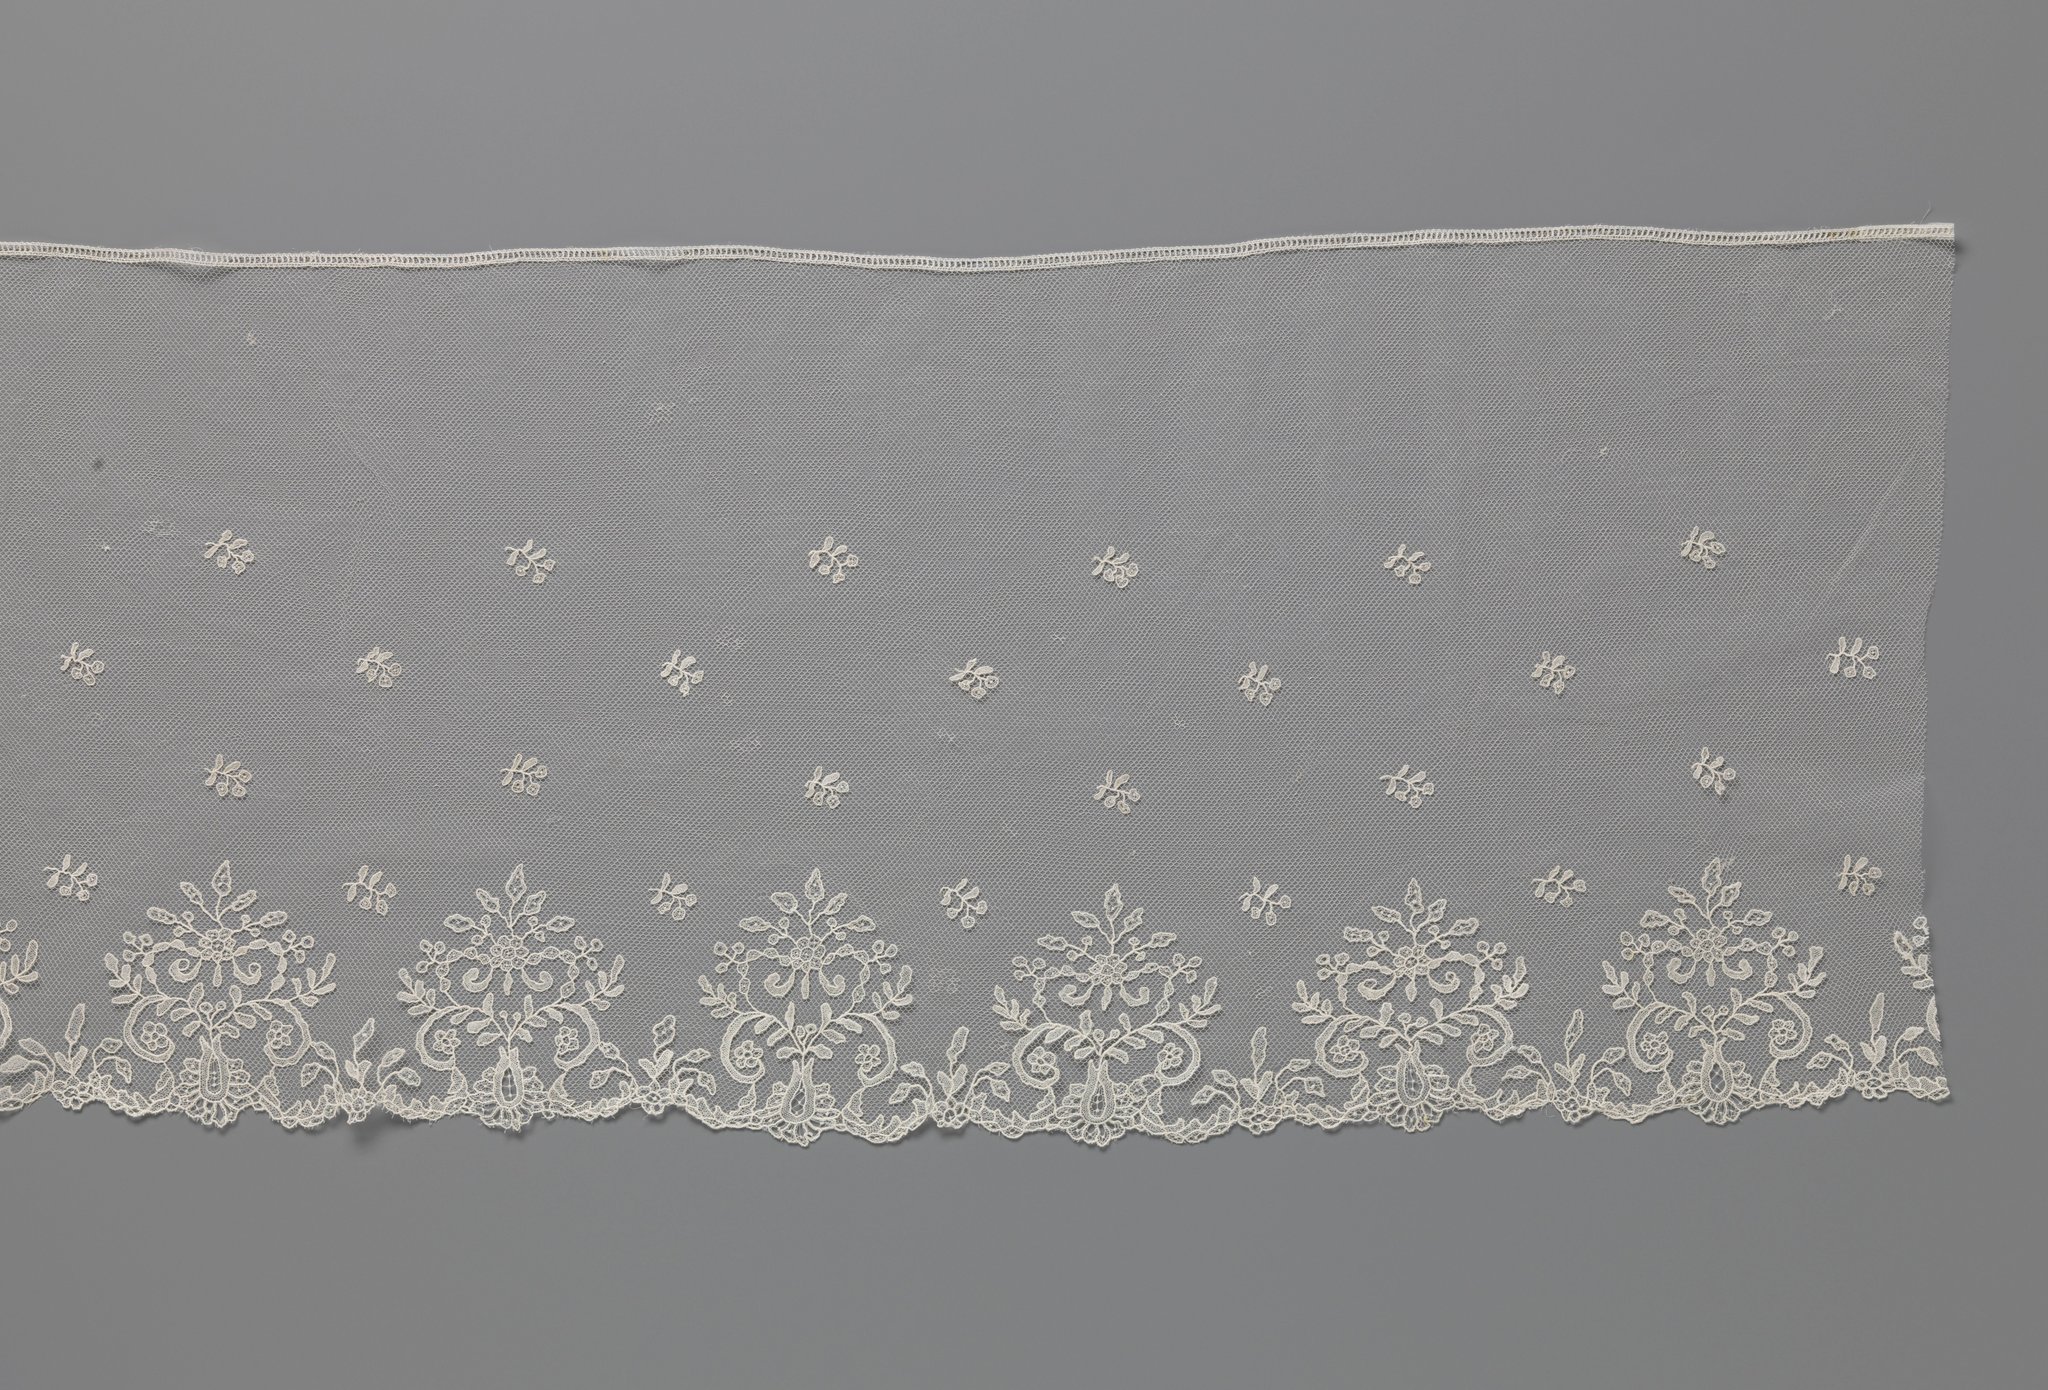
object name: strip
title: Strook applicatiekant met rozetbloemen in symmetrische bladertakken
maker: Anonymous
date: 1840-1850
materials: linen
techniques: lace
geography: brussels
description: Strook naturelkleurig applicatiekant: naaldkant geappliceerd op machinale tule. Strooipatroon van vier rijen bladertakjes op een fijne zeshoekige maasgrond. Langs de onderrand een repetitief motief van een symmetrische bladertak met één rozetbloem in het centrum en één rozetbloem in elk van de twee voluten daaronder. De tak ontspringt vanuit een hangende bloem met druppelvormig hart, waarvan de bloemblaadjes onderdeel zijn van de schulpenrand langs de onderzijde. Verschillende siergronden in de motieven en reliëfcontouren van draadbundels. De bovenzijde is afgezet met een rand kloskant.